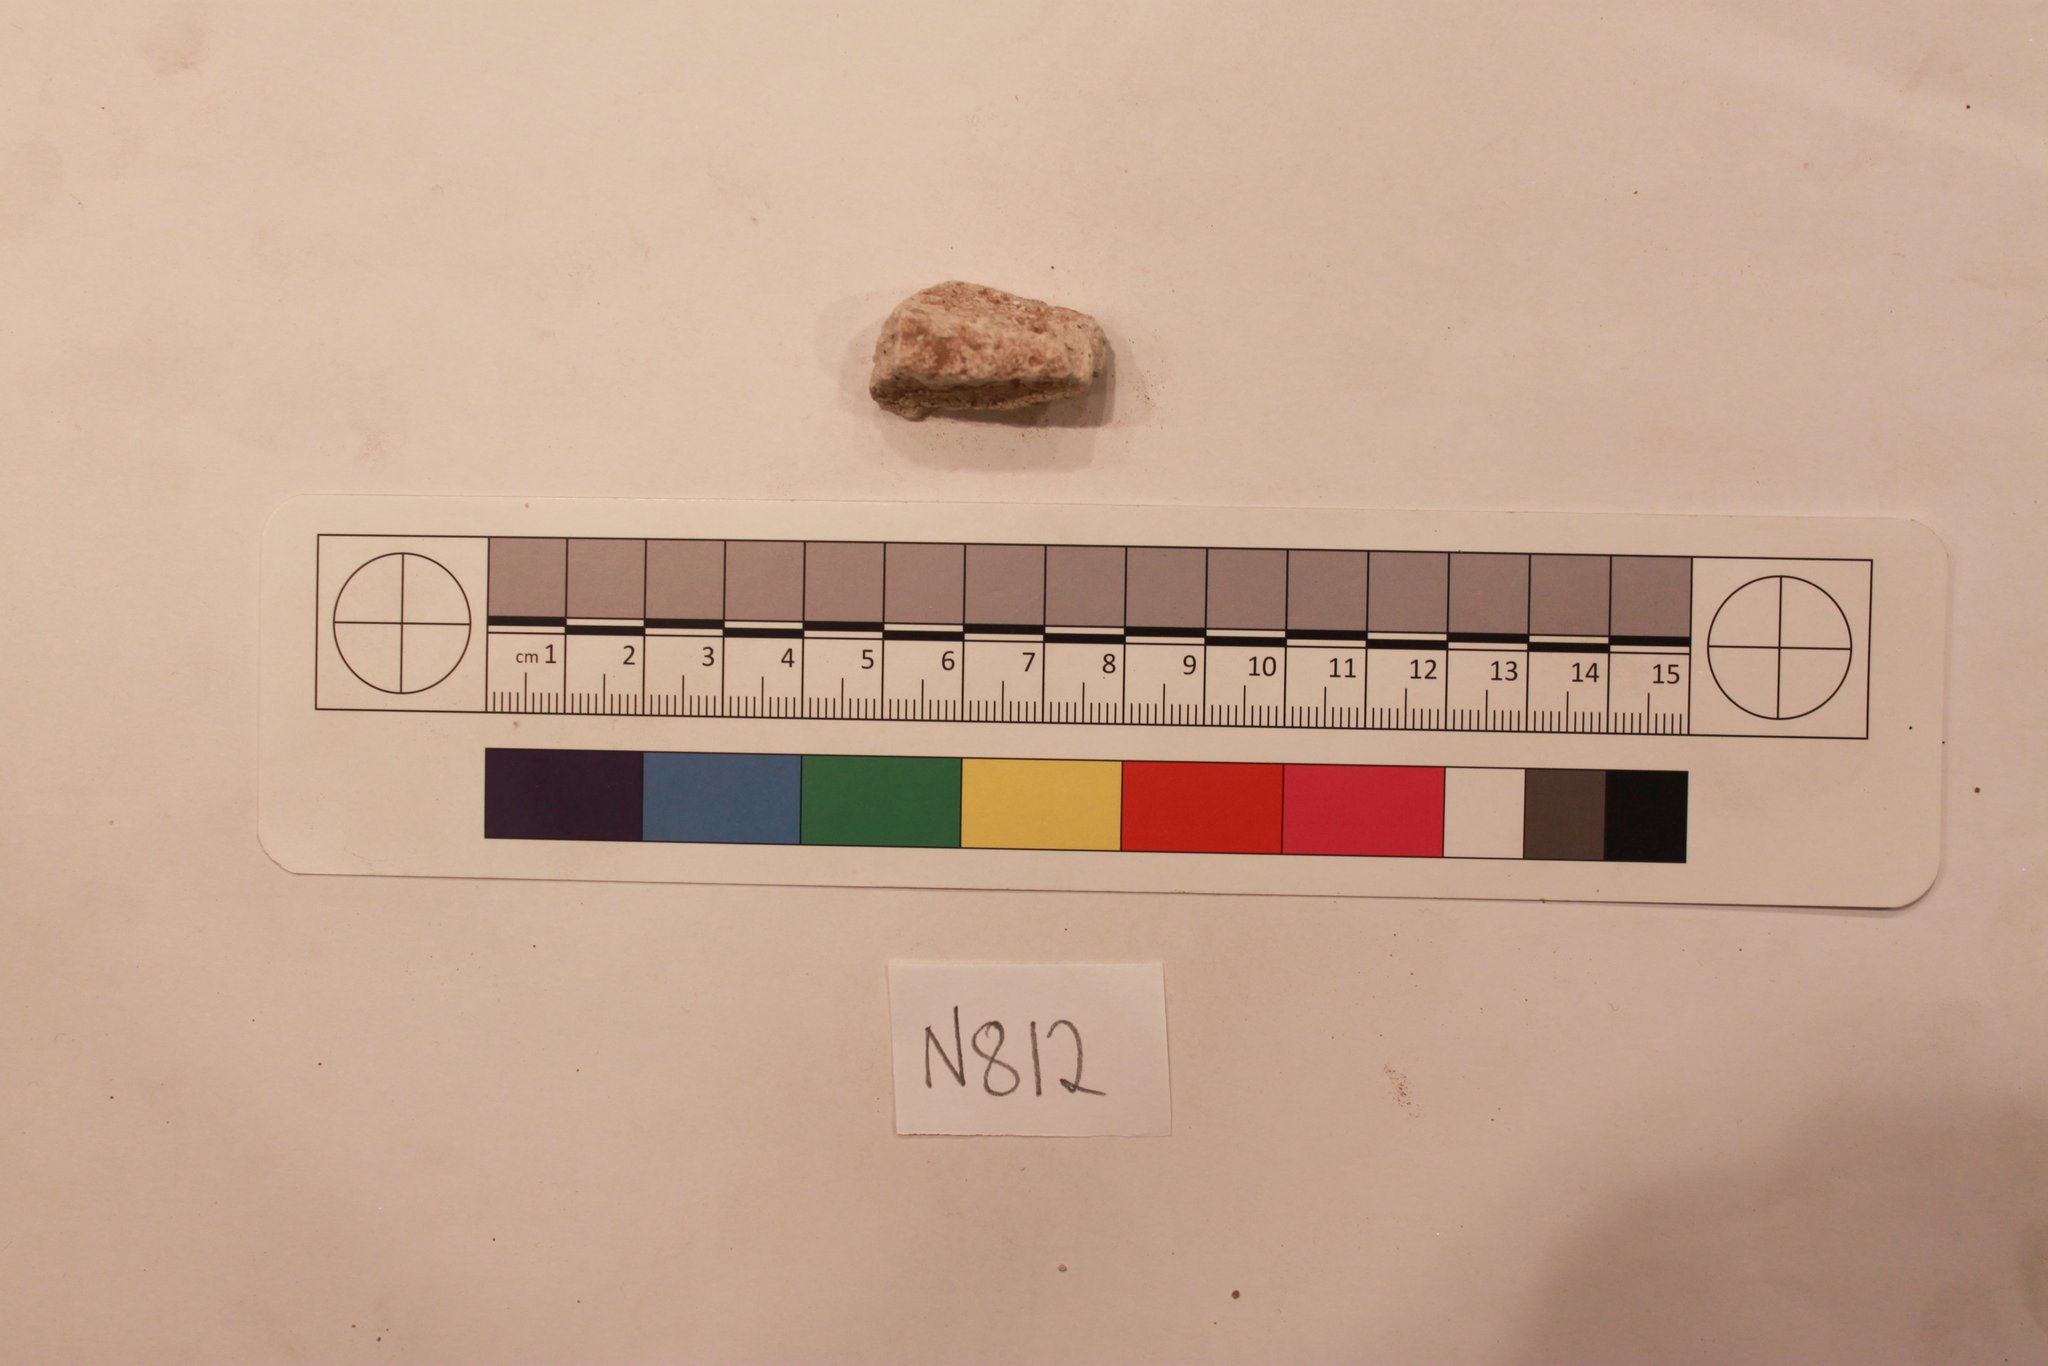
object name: fragment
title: Stucco Fragment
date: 701-1200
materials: plaster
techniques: carving, painting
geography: iran